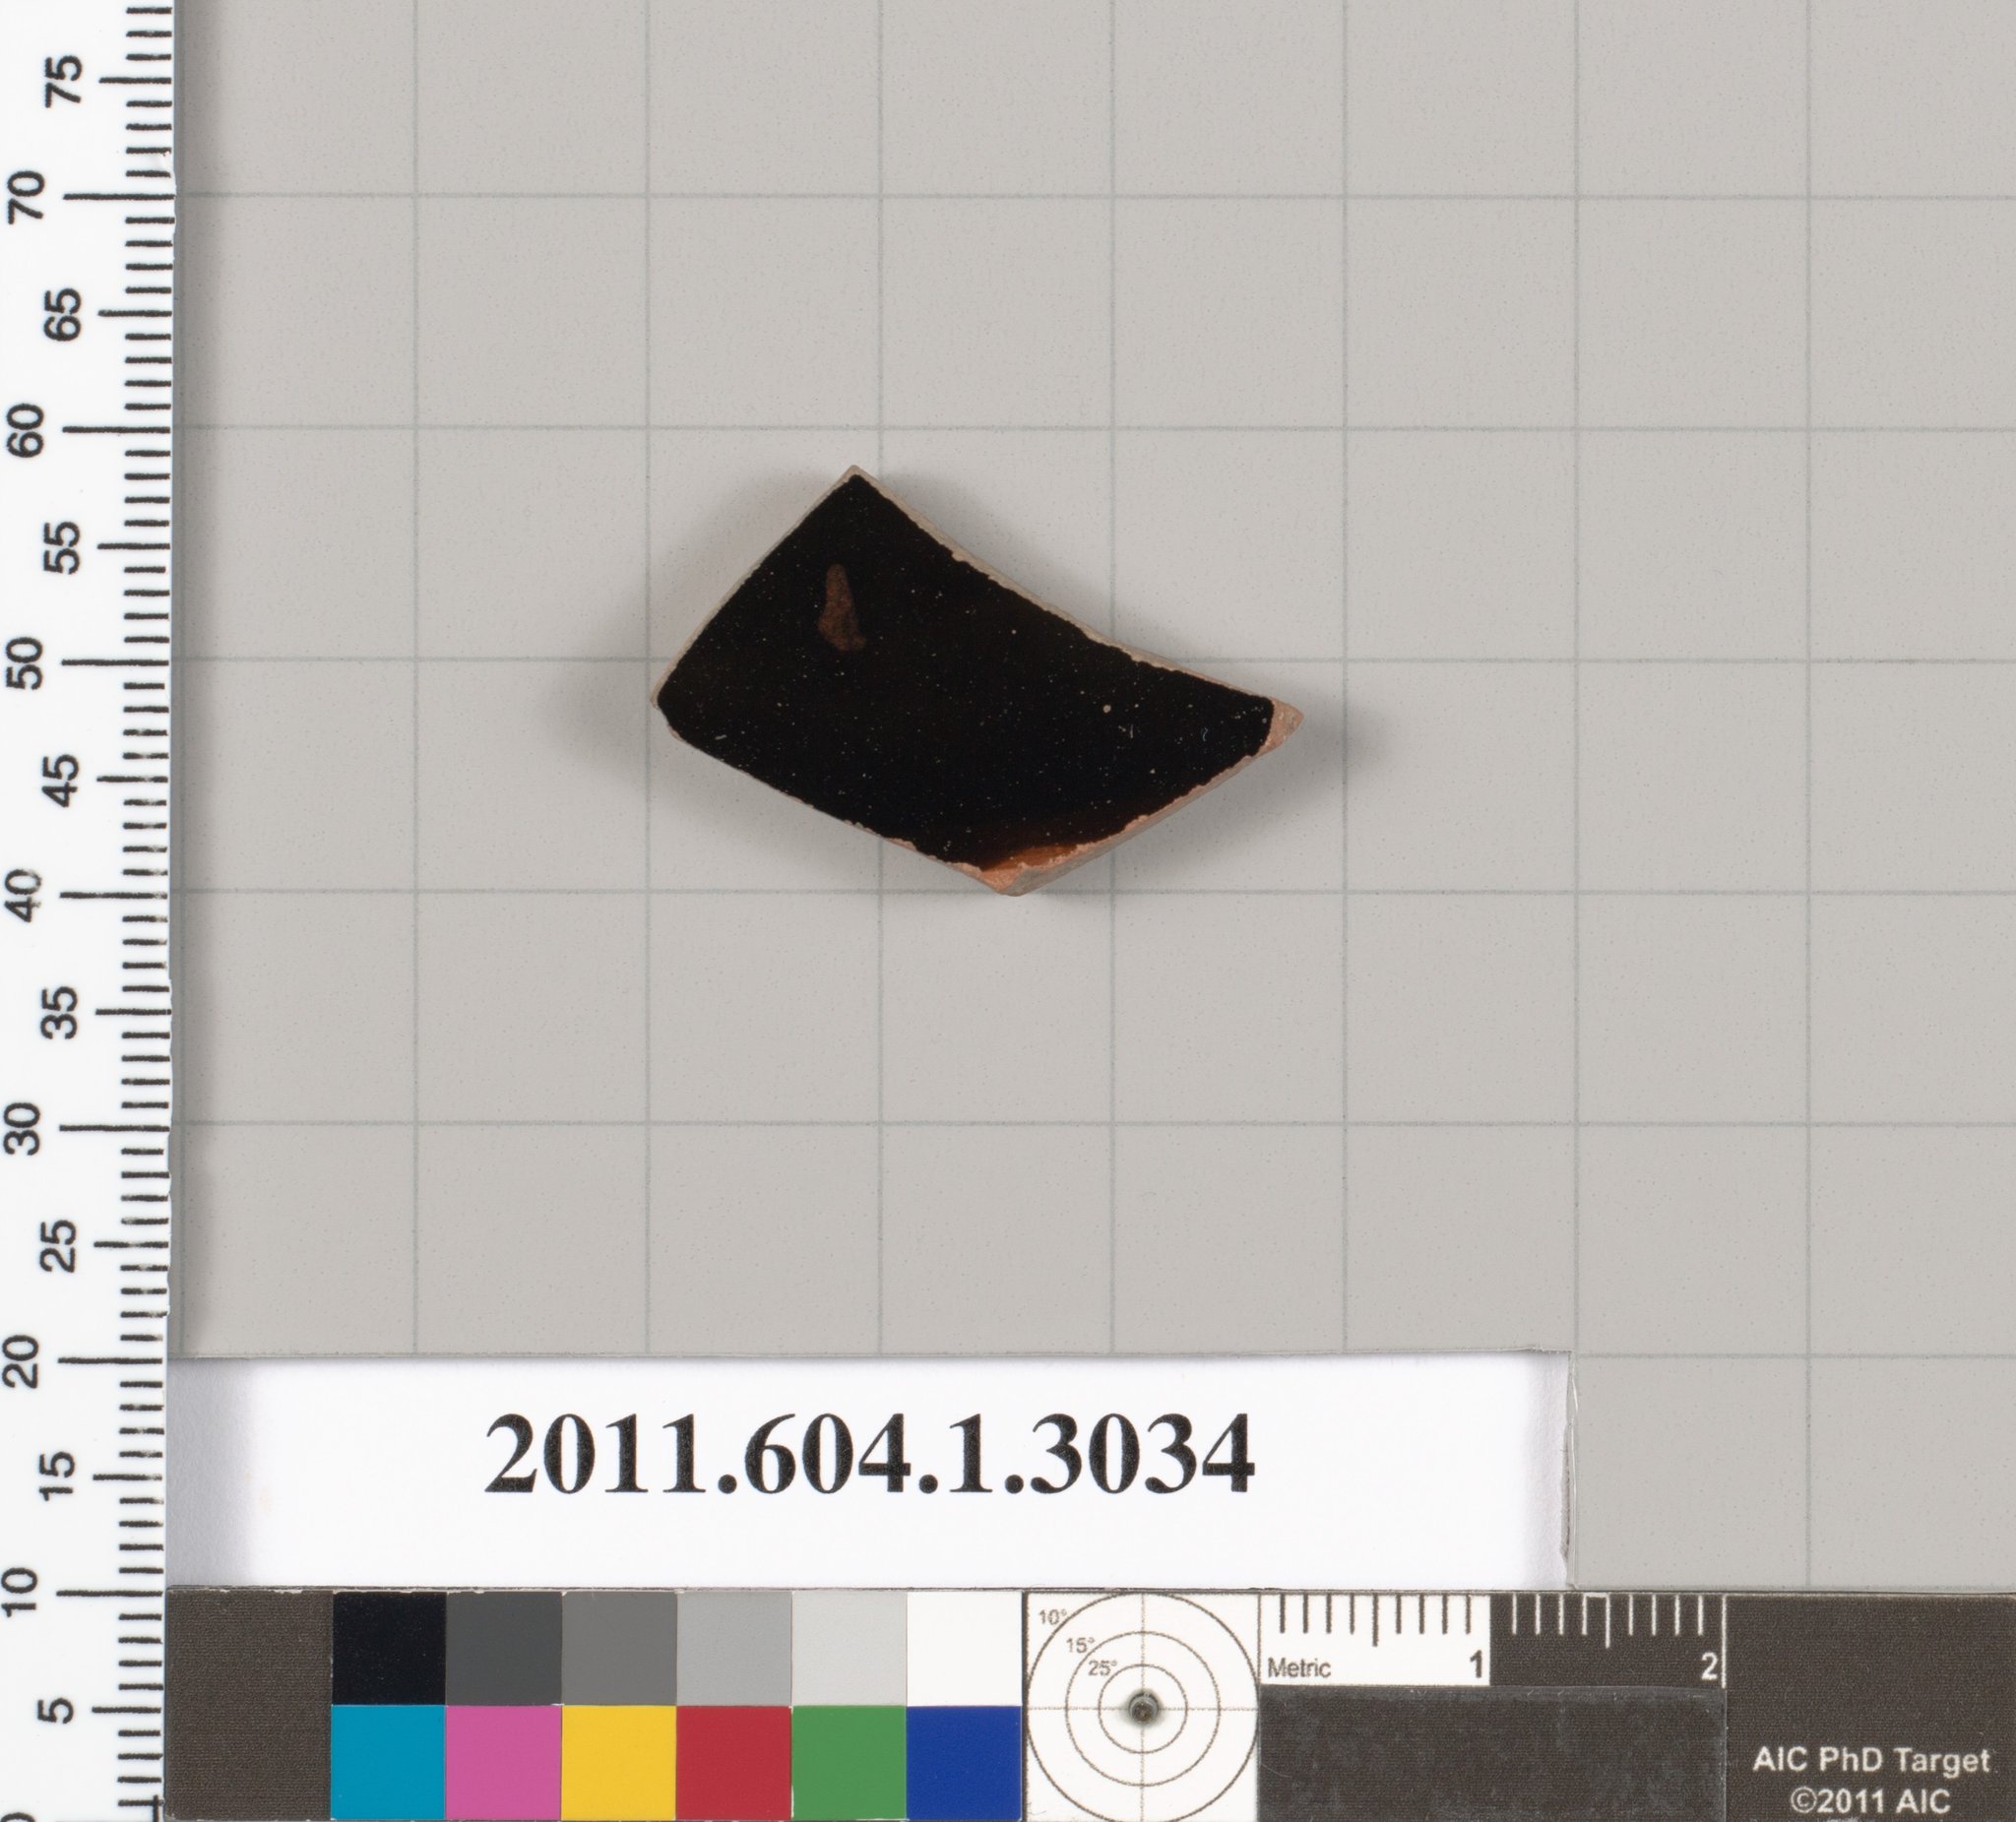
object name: kylix fragment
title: Terracotta fragment of a kylix (drinking cup)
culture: greek, attic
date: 520-480 BCE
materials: terracotta